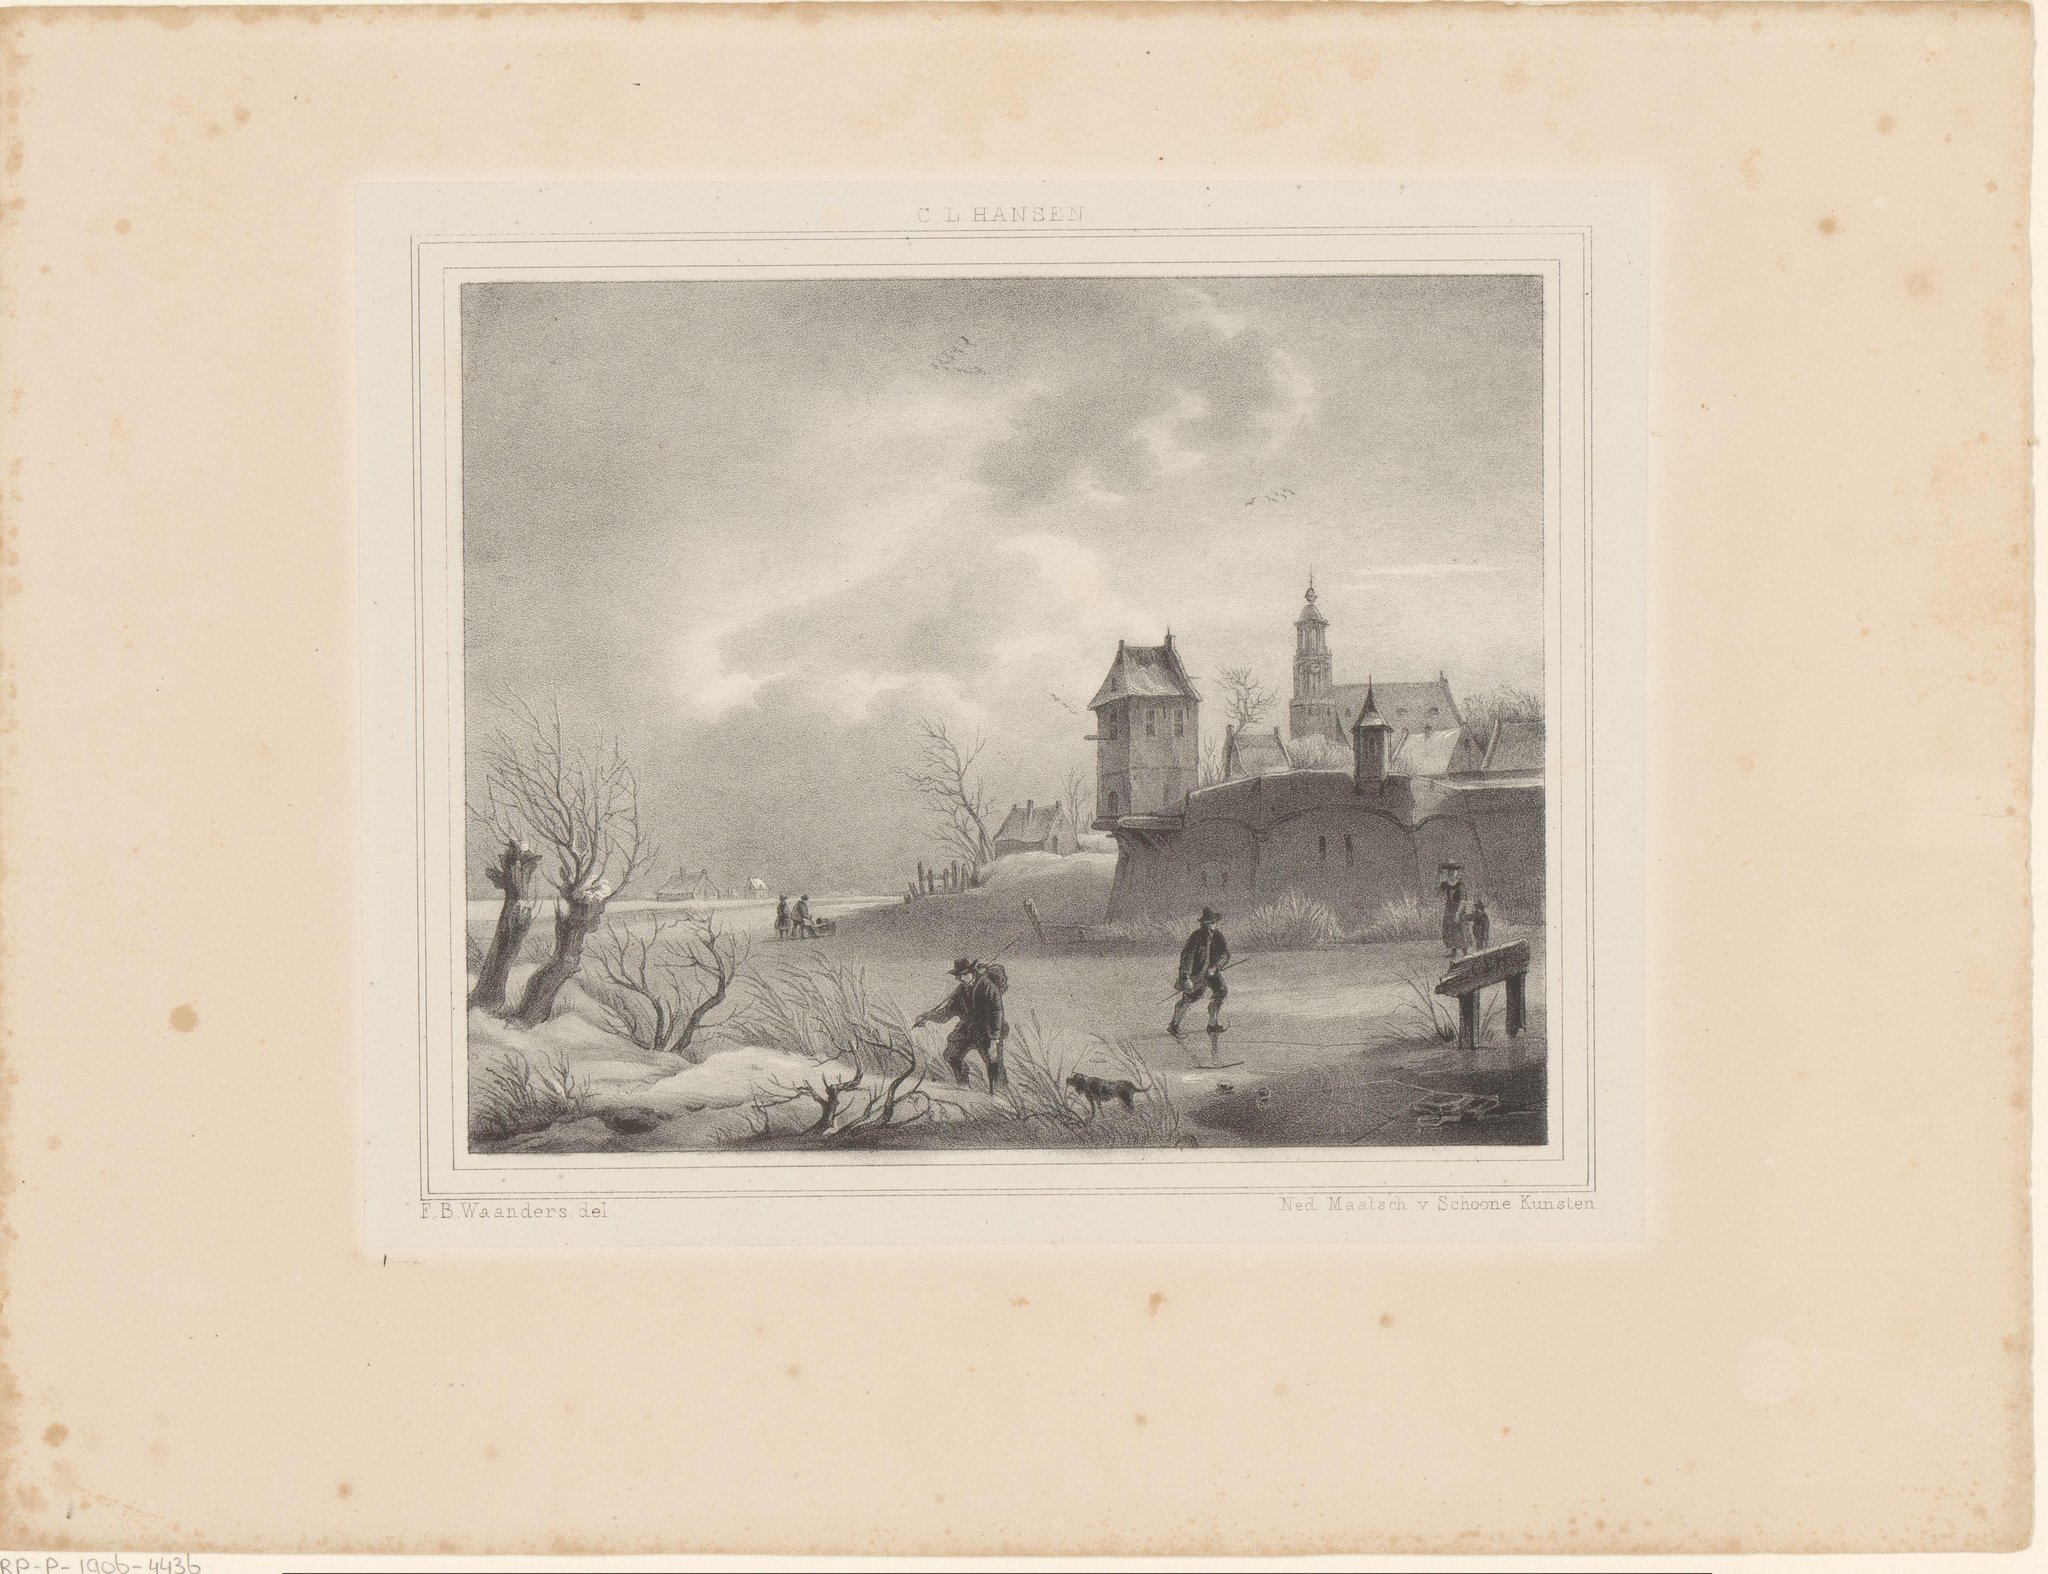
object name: print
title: Schaatsers op bevroren rivier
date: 1842-1843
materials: paper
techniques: lithograph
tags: skates (winter sports)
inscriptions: collector's mark: Lugt 2228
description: Figuren schaatsen op een bevroren rivier. Rechts een stadsmuur met toren en in de achtergrond een kerk.